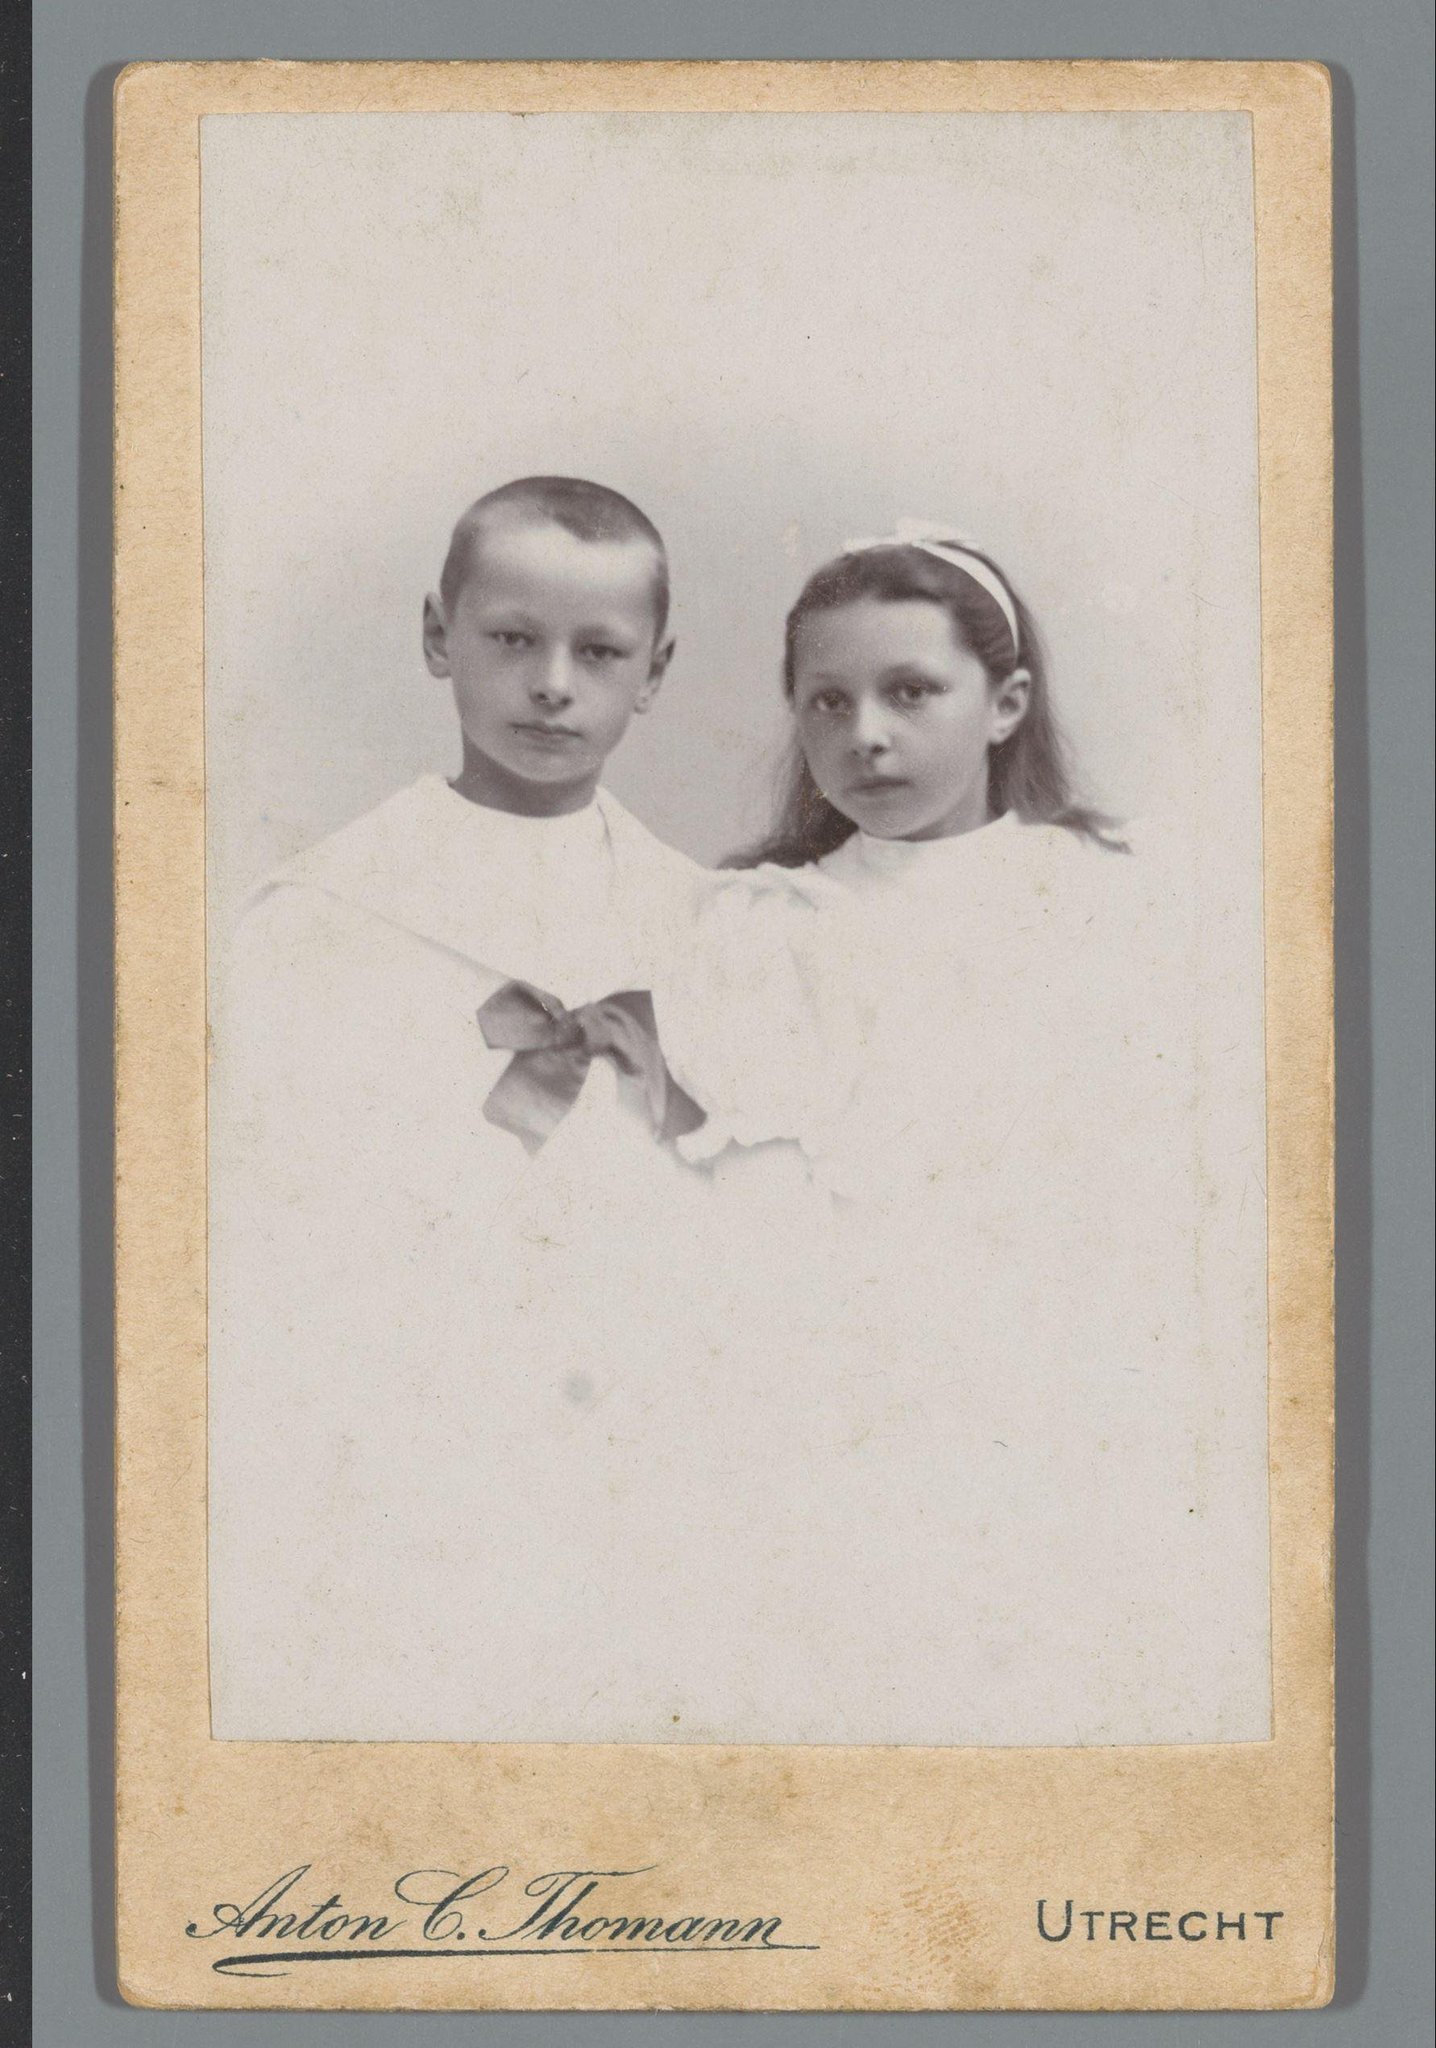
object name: carte de visite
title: Portret van twee onbekende kinderen, familie van G.N.P. van Eijk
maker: anton cornelis thomann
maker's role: fotograaf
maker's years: 1873-1946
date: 1900-1901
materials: paper, cardboard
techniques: collodion silver print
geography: utrecht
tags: child between toddler and youth (of undetermined sex), historical persons not known by name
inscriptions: inscription: ‘Anton C. Thomann/ Utrecht (...) beslist artistique belichting.’